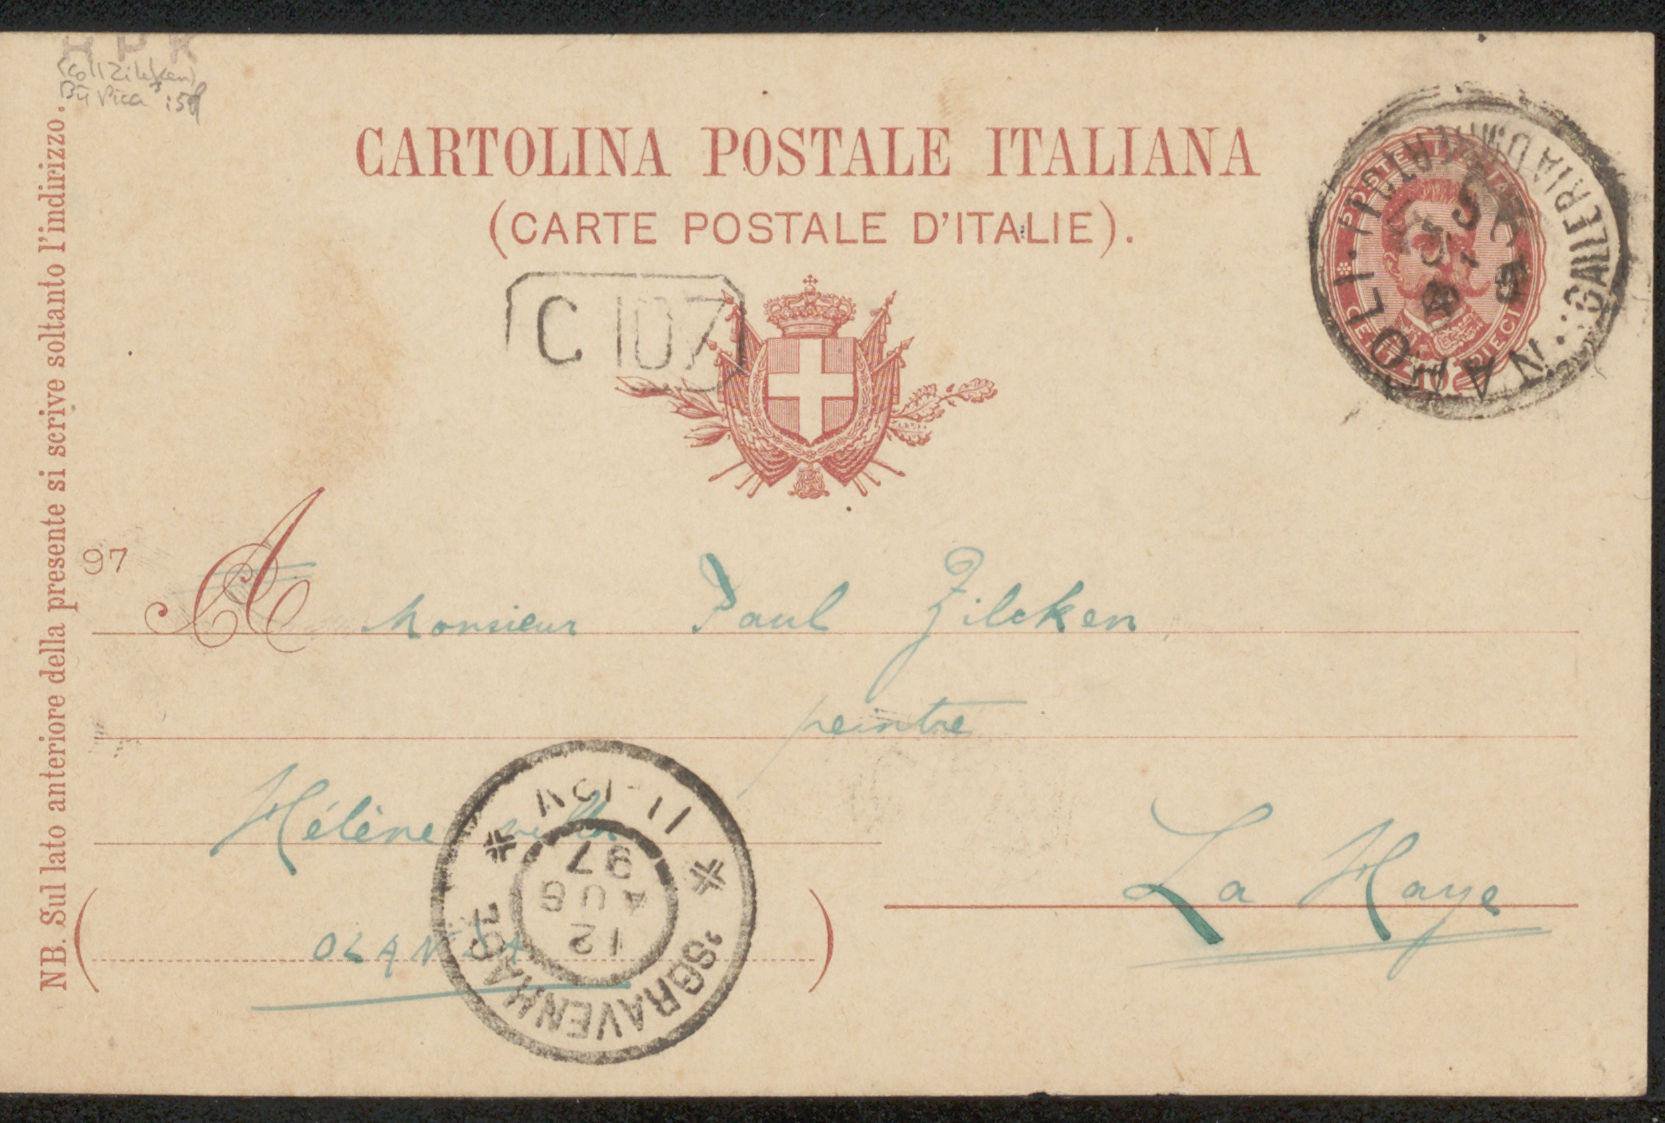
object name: postcard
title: Briefkaart aan Philip Zilcken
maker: vittorio pica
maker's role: criticus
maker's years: 1864-1930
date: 1897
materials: cardboard, ink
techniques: pen, writing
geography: naples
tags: jozef israëls, matthijs maris, the hague, painter, print maker, draughtsman, jacob maris, philip zilcken, photography, cinematography, money, printed matter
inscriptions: collector's mark: ‘RPK’